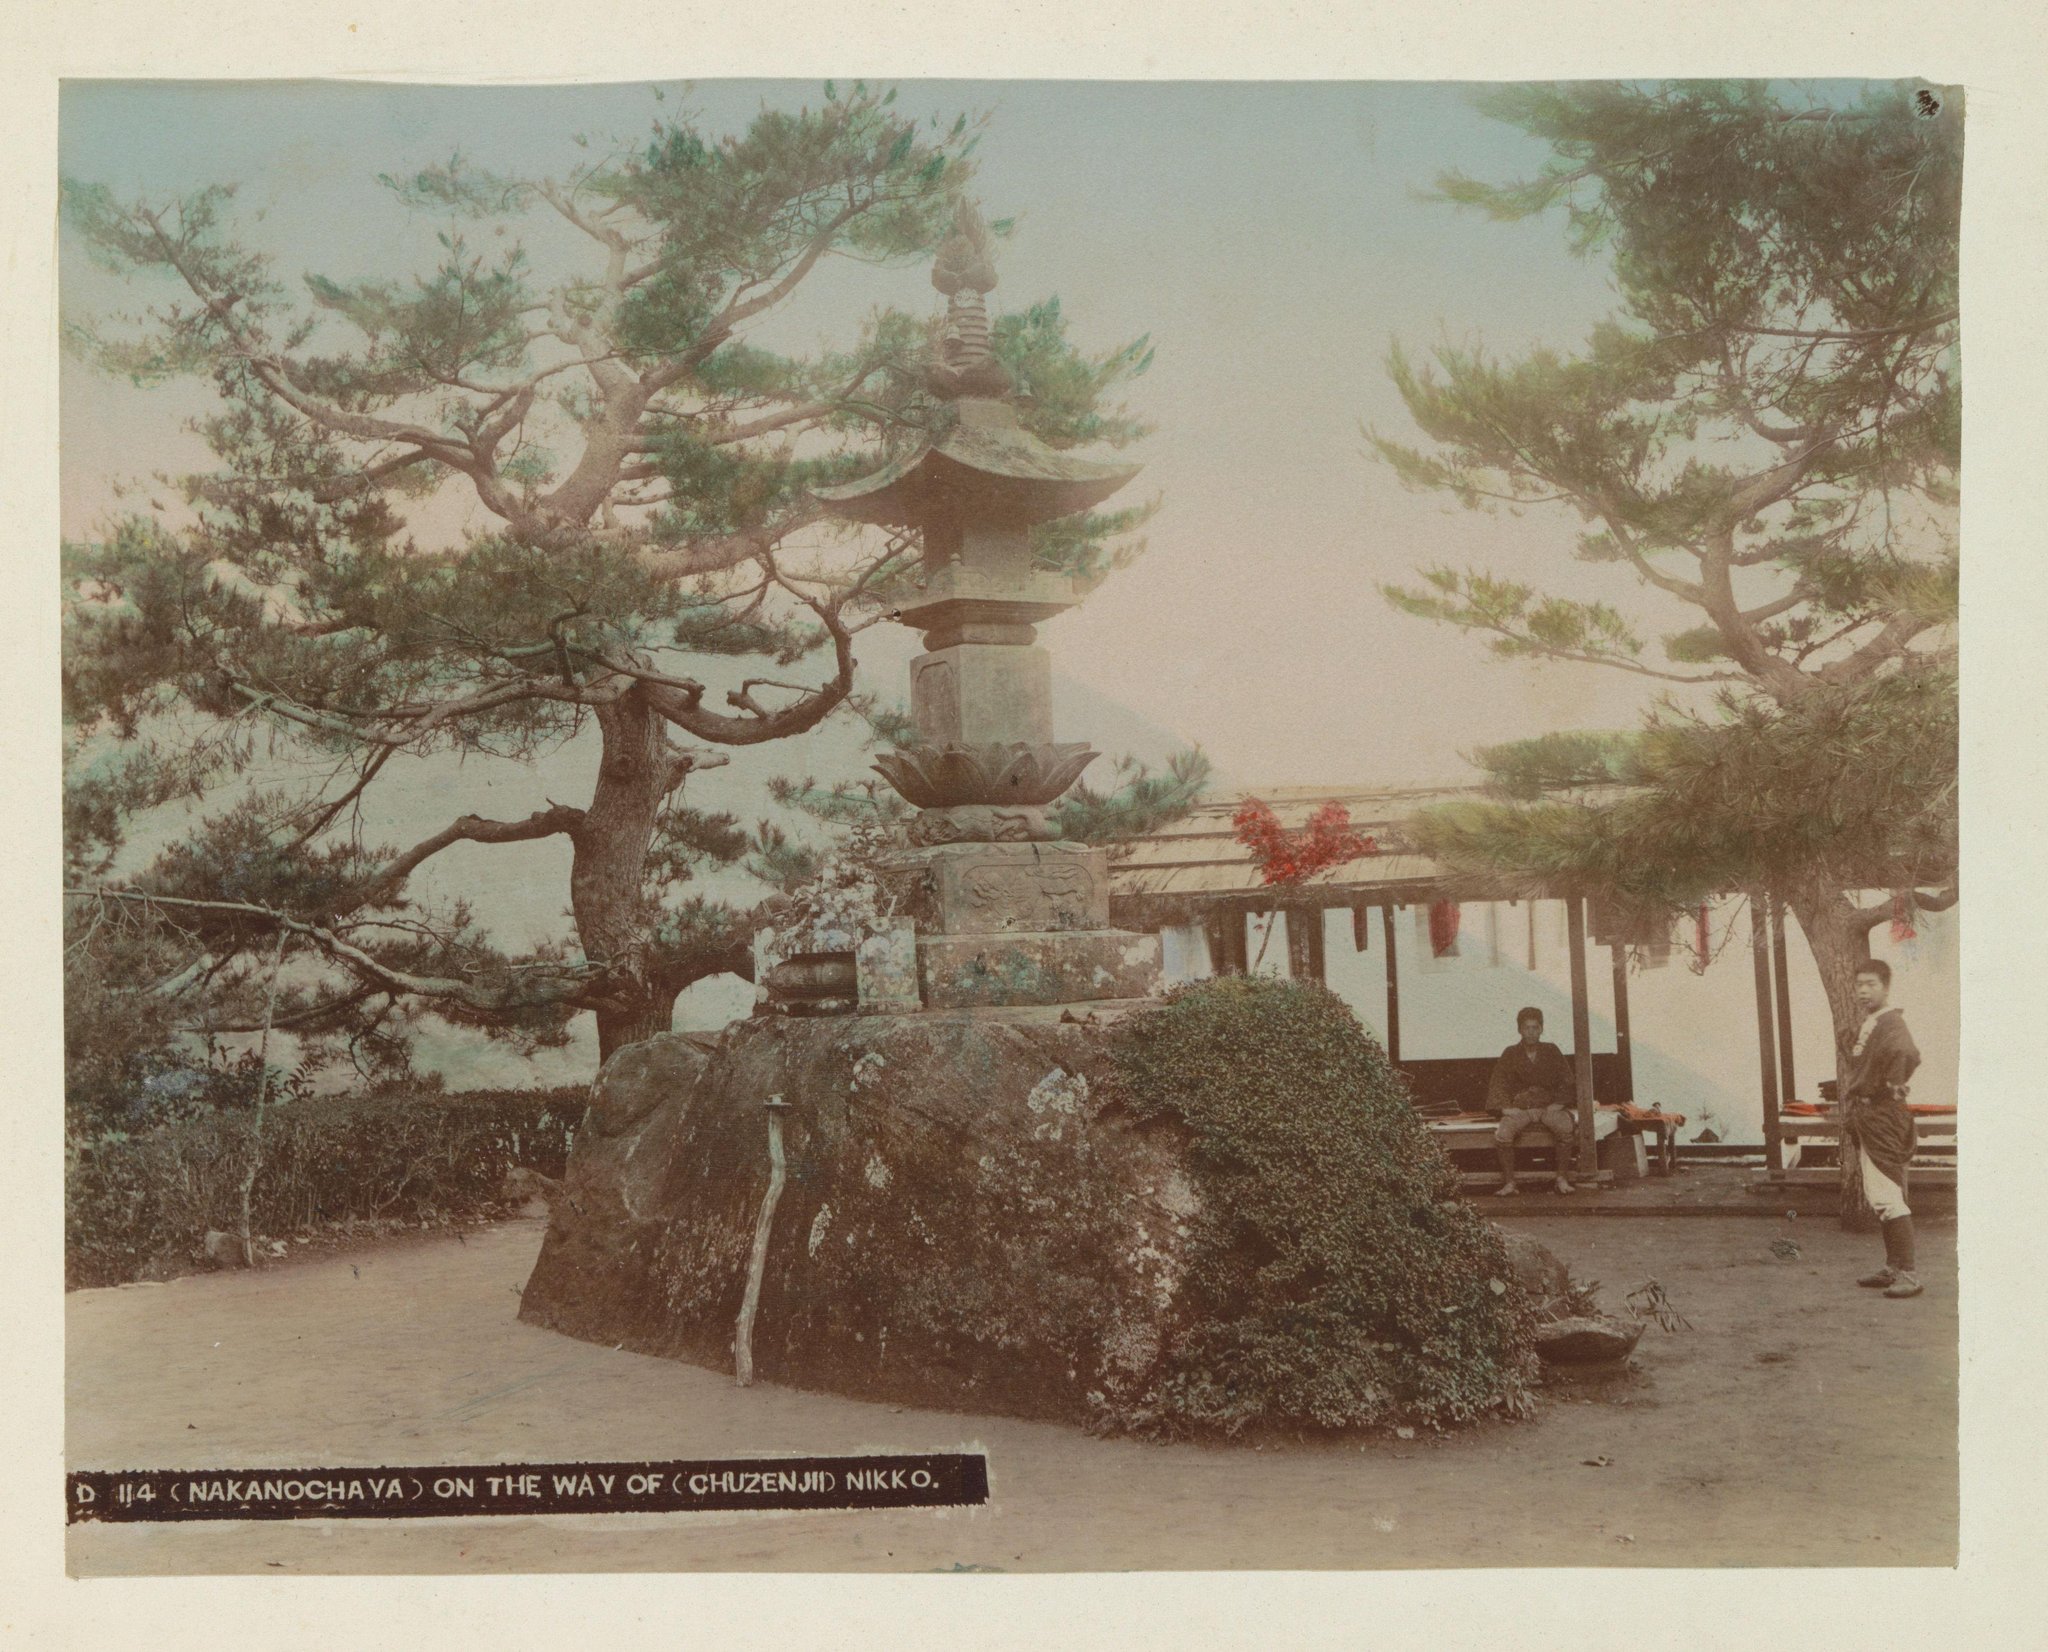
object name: photograph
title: (Nakanochaya) on the way of (Chuzenjii) Nikko.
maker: Anonymous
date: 1870-1900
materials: cardboard, paper, photographic support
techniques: albumen print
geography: nikko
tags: nikko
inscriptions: negative number: ‘D 114’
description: Onderdeel van Reisalbum met foto's van bezienswaardigheden in Japan.